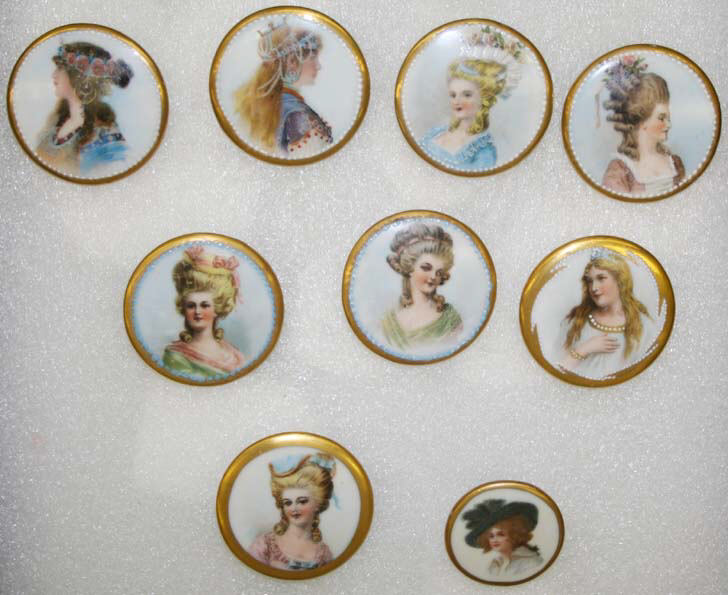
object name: button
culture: british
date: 1890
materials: porcelain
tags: portraits,women